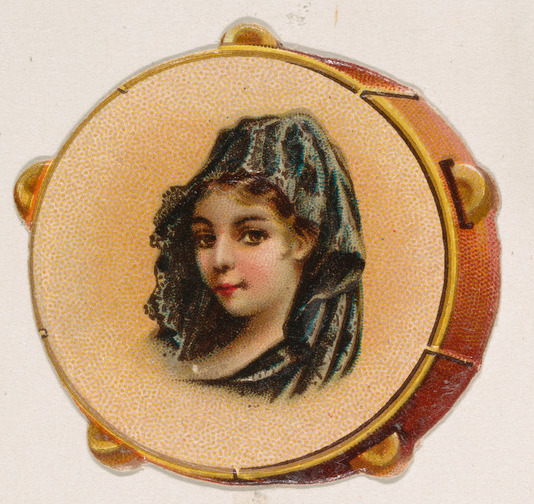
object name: print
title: Tambourine, from the Novelties series (N228, Type 4) issued by Kinney Bros.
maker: kinney brothers tobacco company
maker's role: publisher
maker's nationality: american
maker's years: 1869-2011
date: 1889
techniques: color lithograph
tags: musical instruments,girls